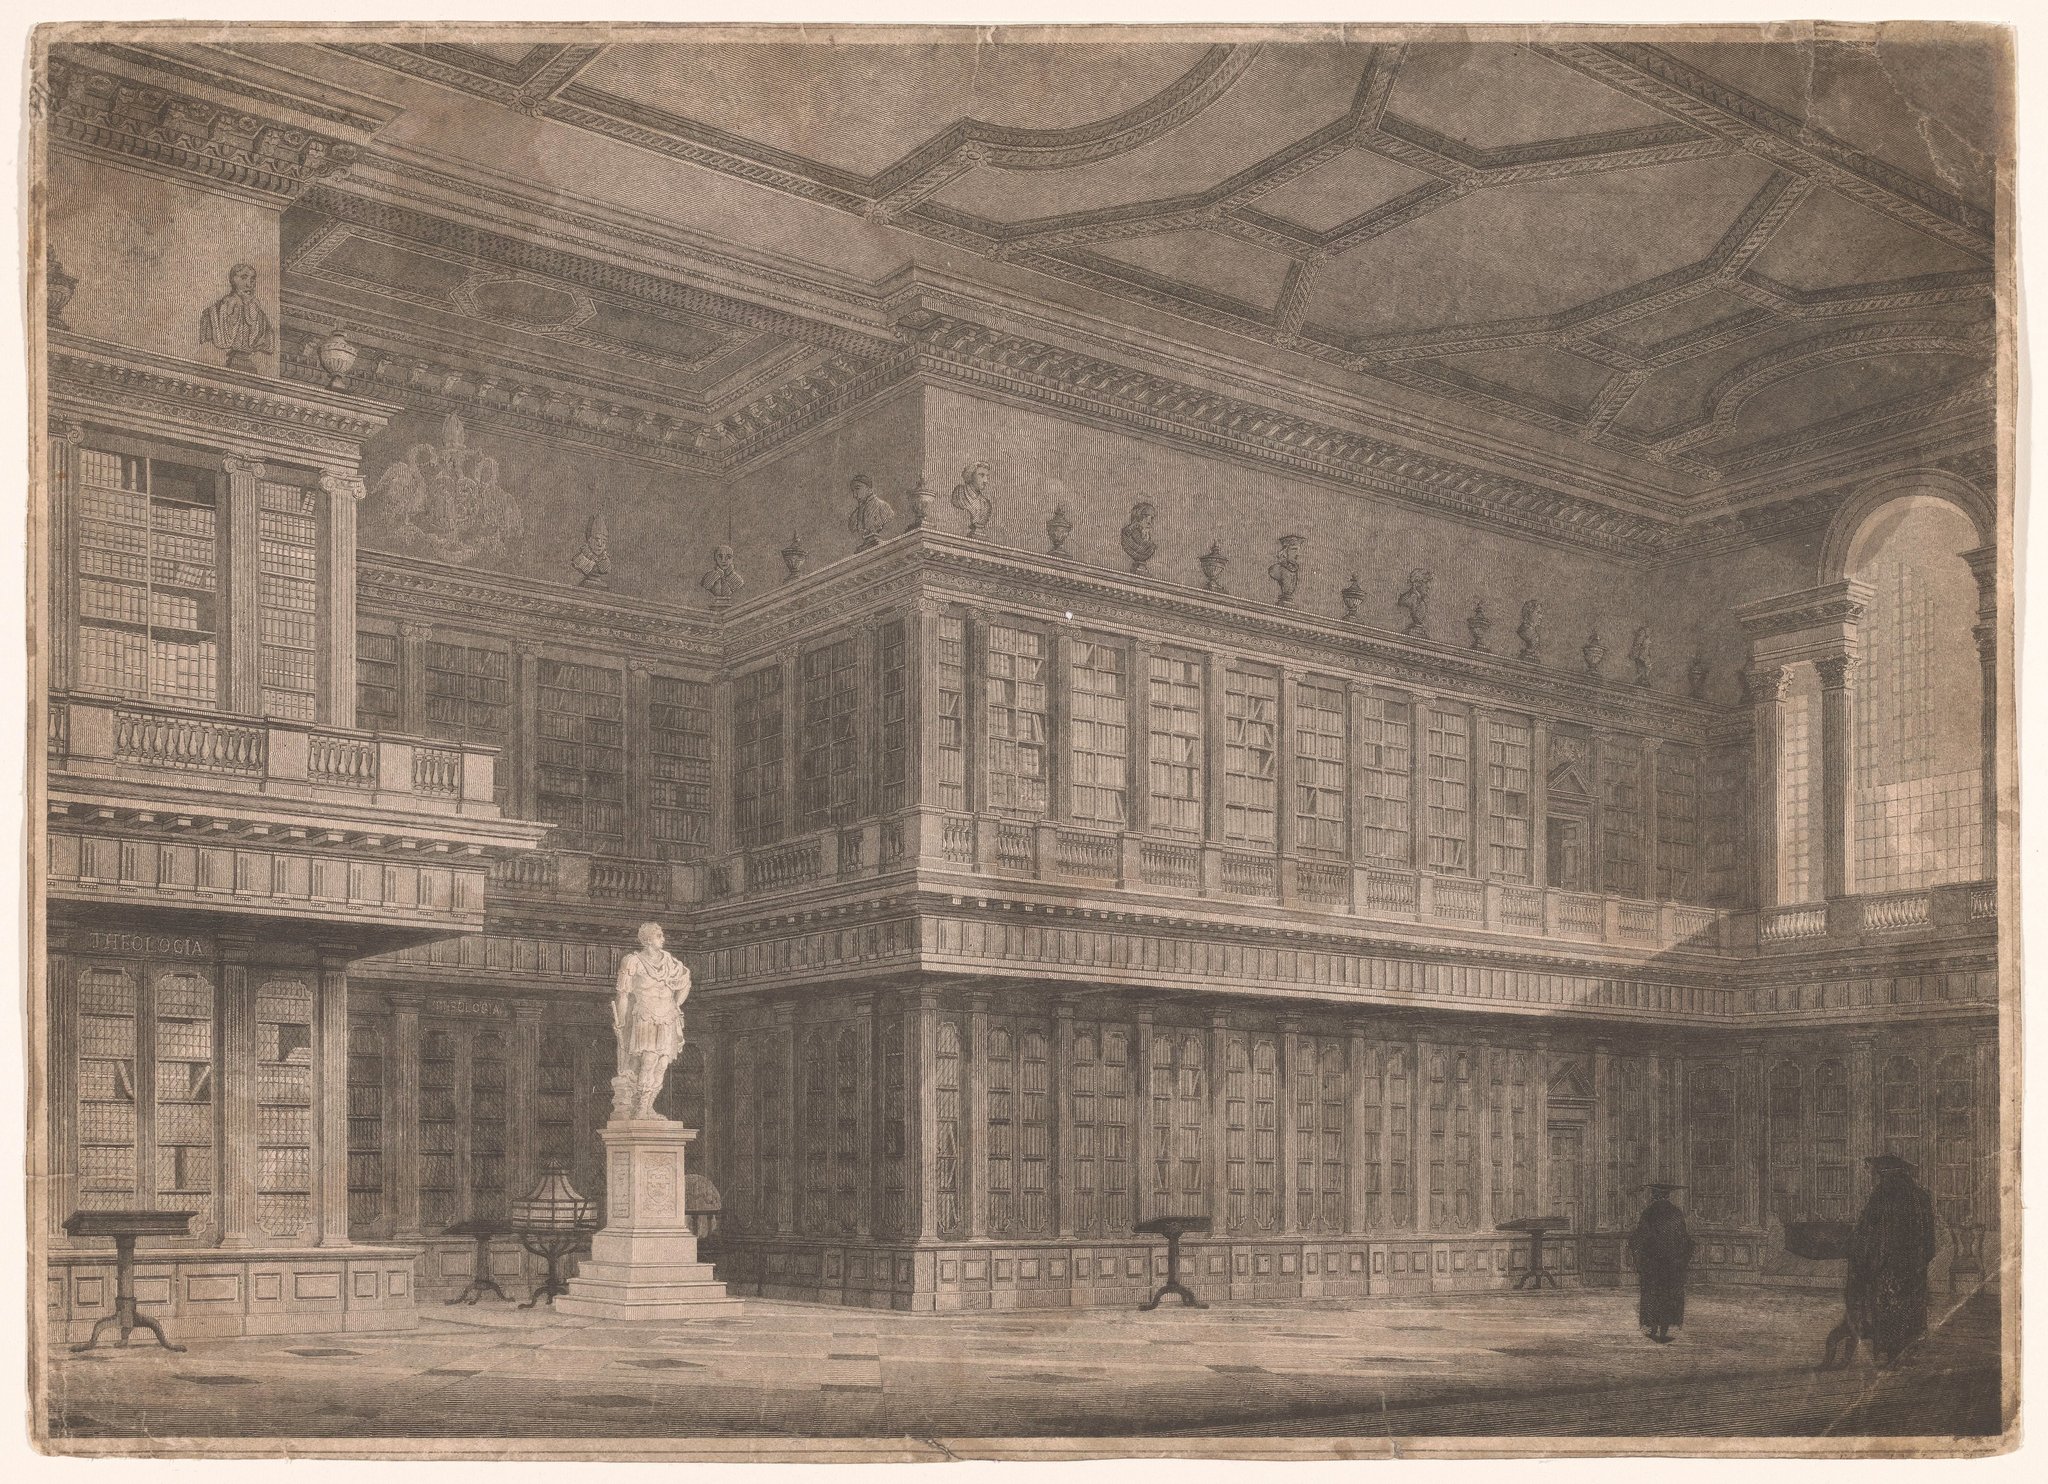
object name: print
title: Interieur van een bibliotheek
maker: Anonymous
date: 1700-1799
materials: paper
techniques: etching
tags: public library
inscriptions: collector's mark: Lugt 2228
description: Interieur van een bibliotheek met boeken verdeeld over twee etages. De boekenkasten op de bovenste etages zijn bekroond met bustes. Op de grond staat een beeld van een man op een sokkel. Verspreid over het vertrek staan vijf lessenaars.